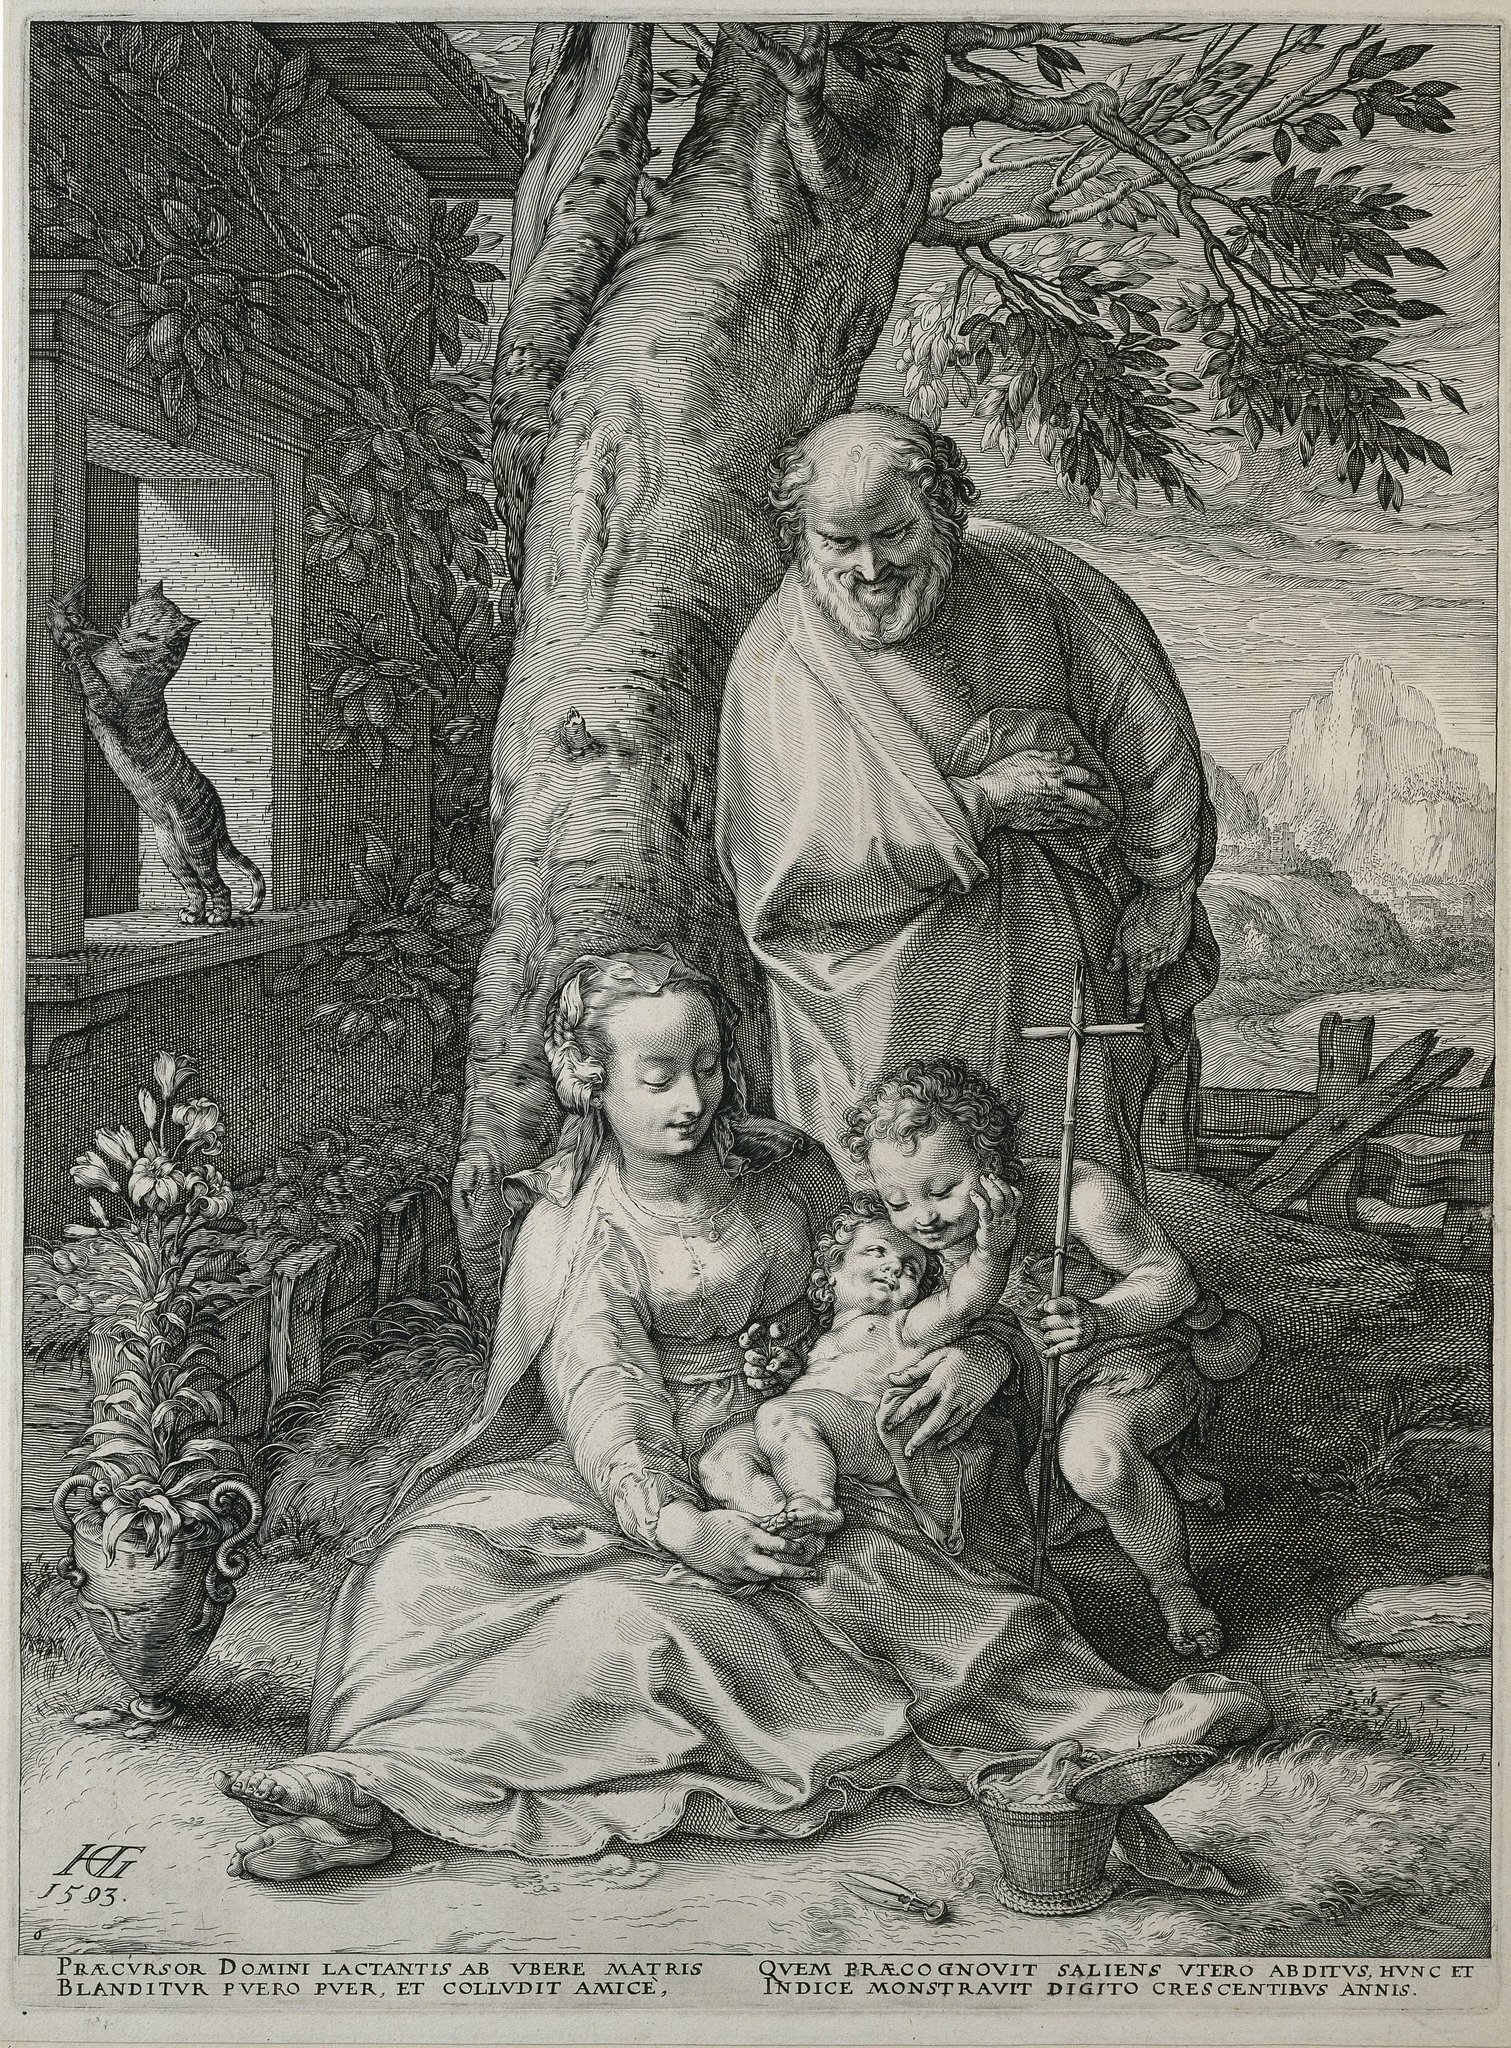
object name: print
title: Meesterstukken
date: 1593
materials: paper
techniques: engraving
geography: haarlem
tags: holy family with john the baptist (as child)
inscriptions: collector's mark: Lugt 240, date: ‘1593.’, caption: ‘PRAECVRSOR DOMINI...CENTIBVS ANNIS.’, signature: ‘HG.’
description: Maria, Jozef, het Christuskind en de kleine Johannes de Doper voor een huisje. Onder de voorstelling vier Latijnse versregels. Deze prent is onderdeel van een serie van zes prenten met scènes uit het vroege leven van Maria. Die worden de 'Meesterstukken' genoemd, omdat Goltzius er het werk van verschillende illustere voorgangers in heeft nagebootst.